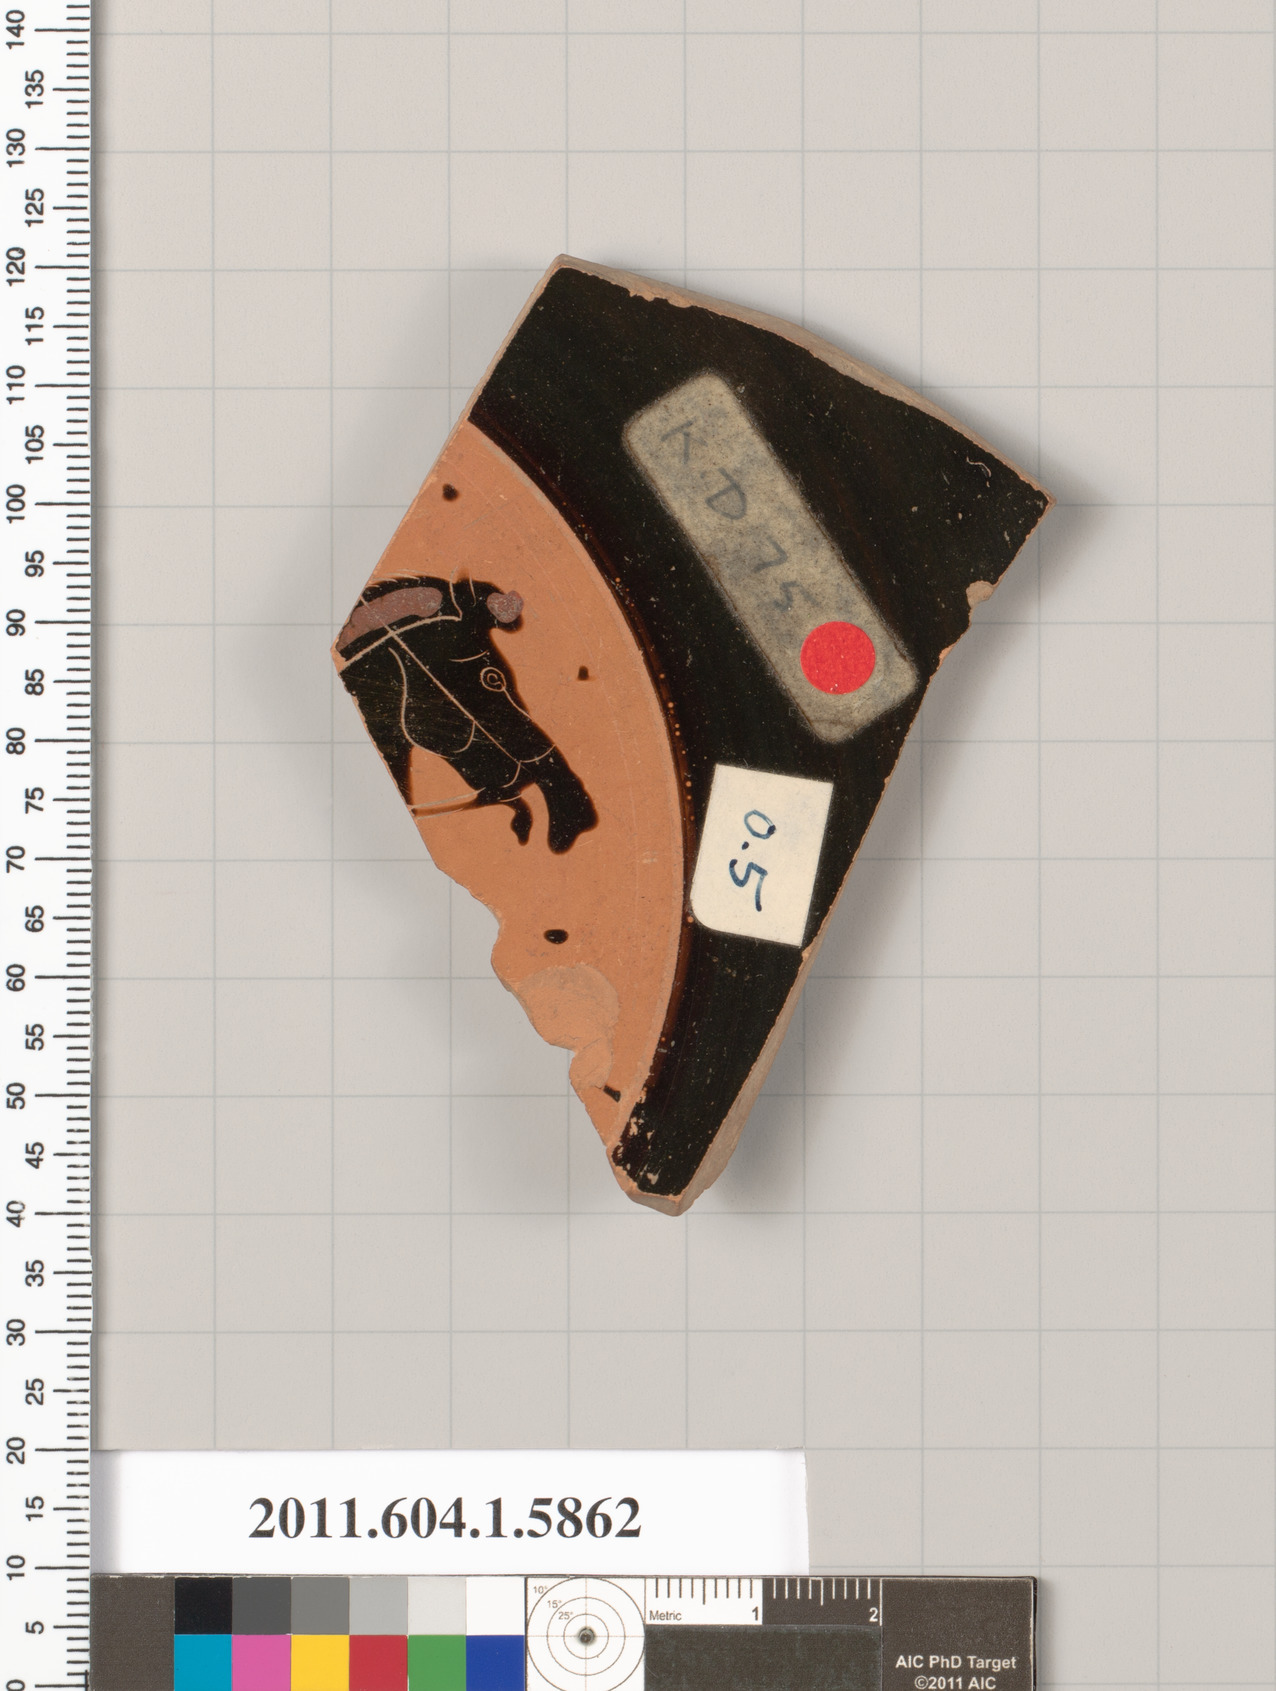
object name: kylix fragment, eye cup, bilingual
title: Terracotta fragment of a kylix (drinking cup)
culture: greek, attic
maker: pheidippos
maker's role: artist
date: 433-567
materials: terracotta